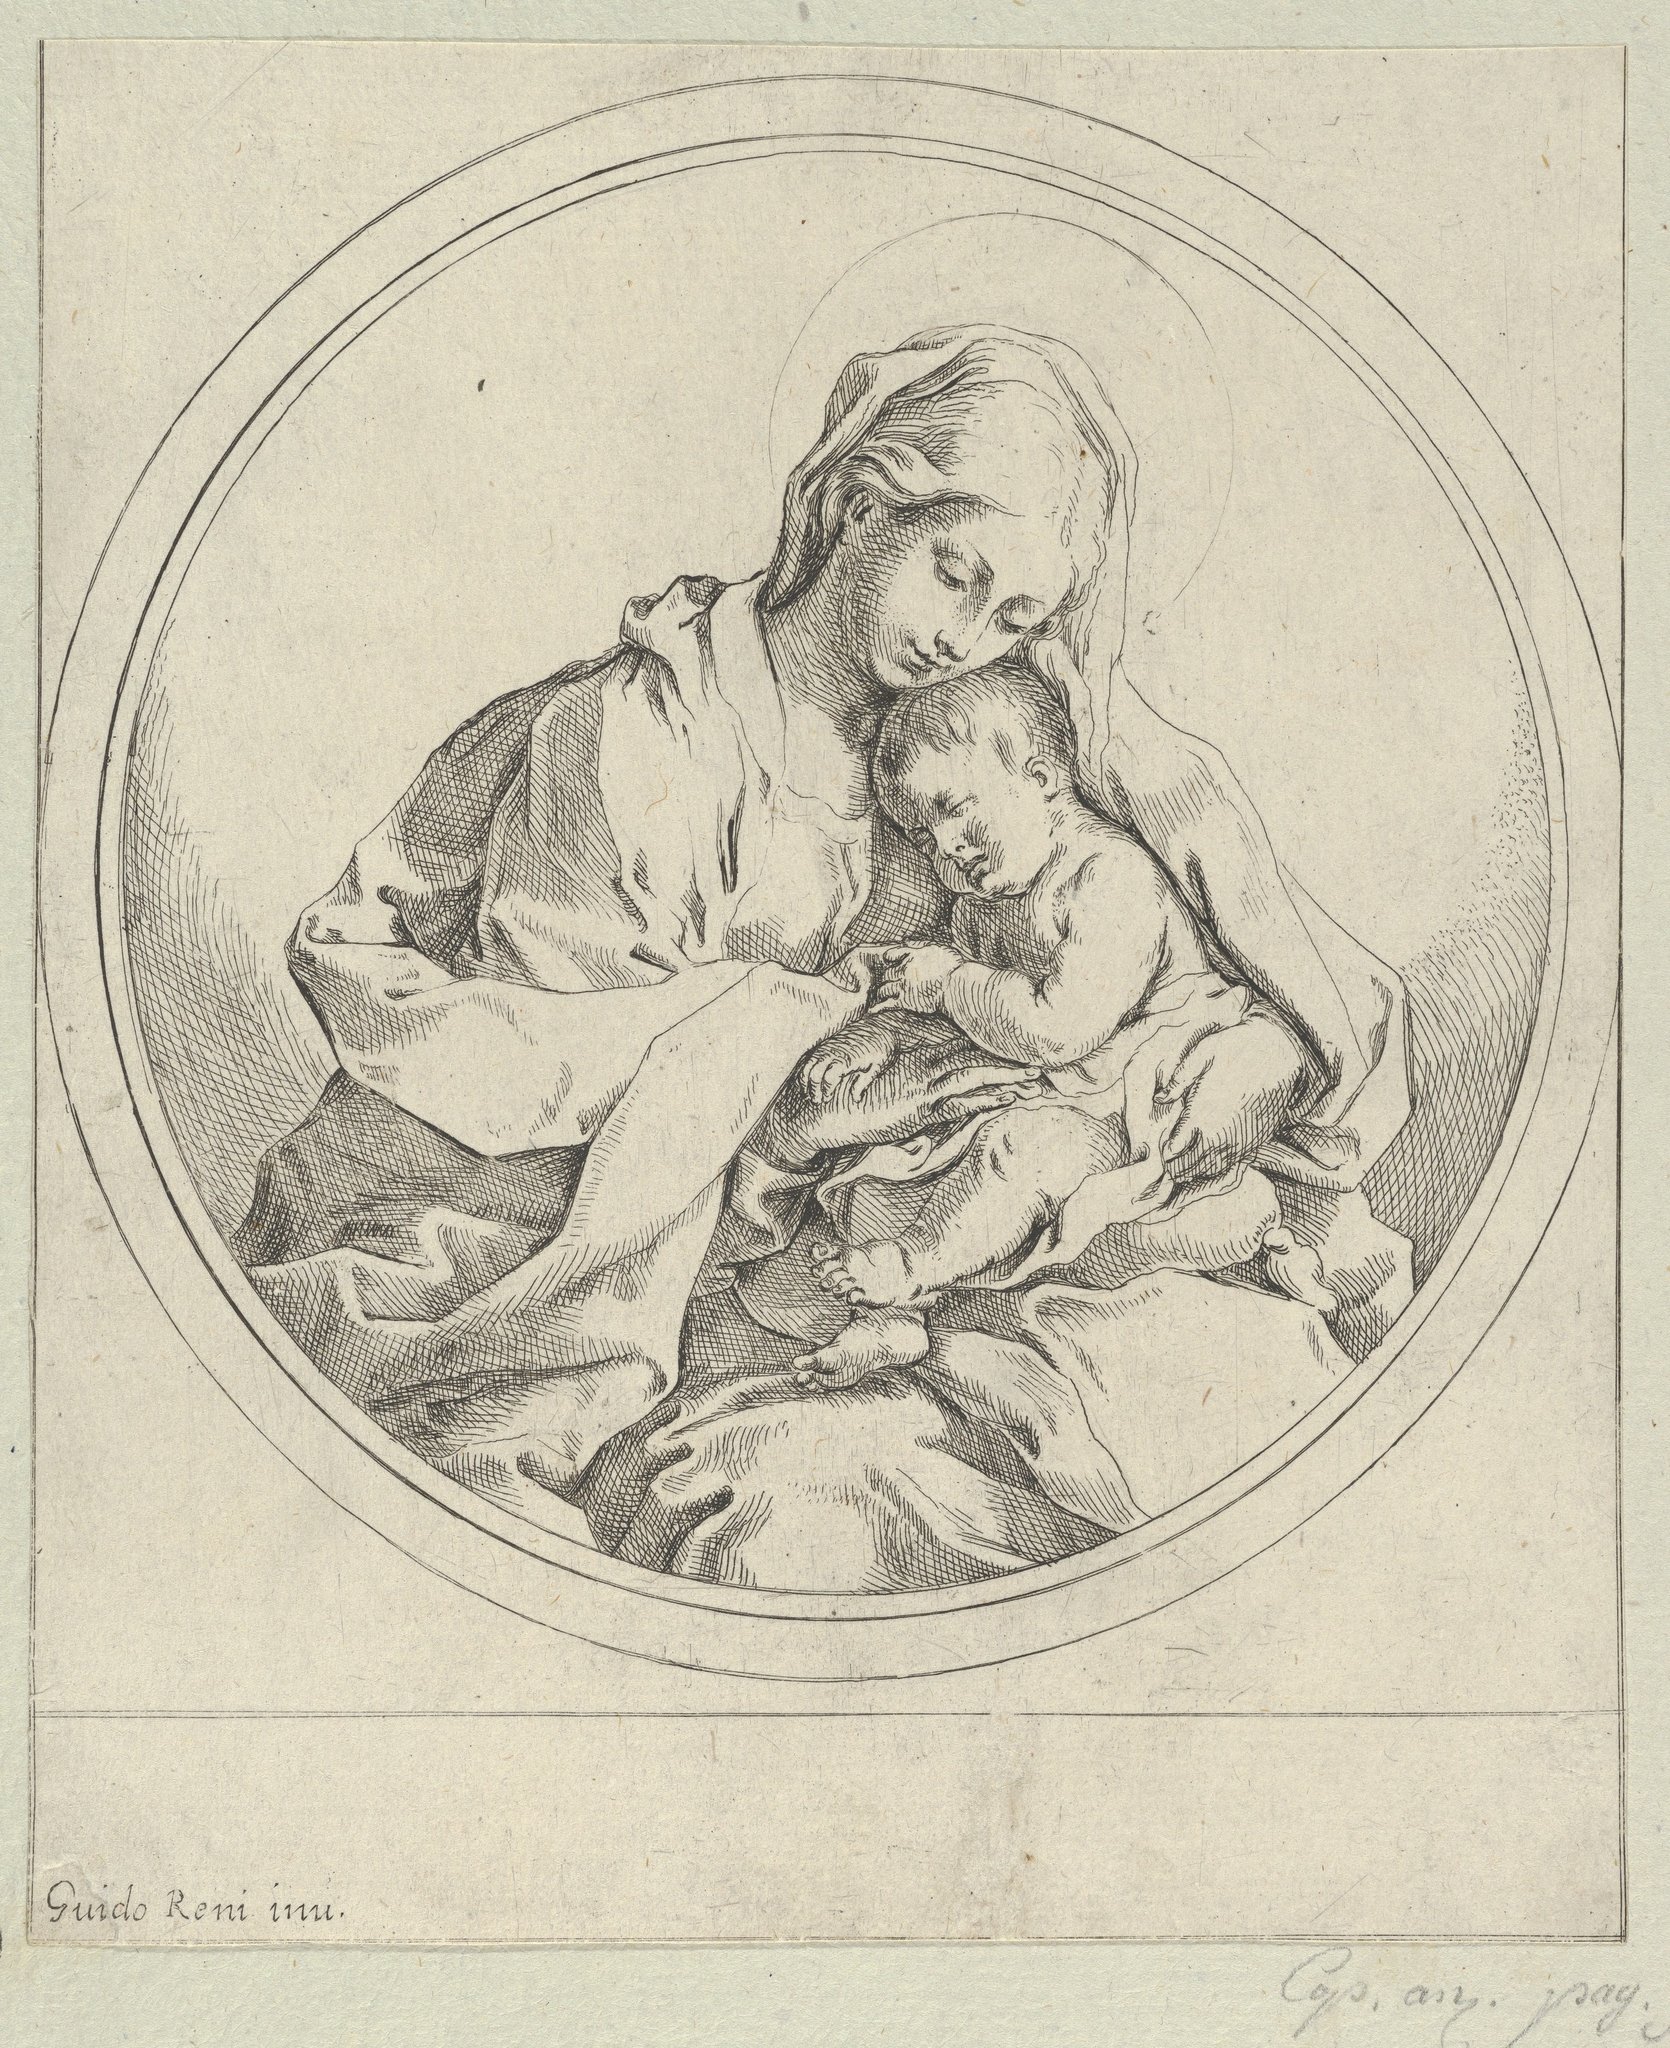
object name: print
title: The Virgin holding the infant Christ, a circular composition, after Reni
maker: anonymous, 17th century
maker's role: artist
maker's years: 1600-1700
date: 1600-1640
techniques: etching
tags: madonna and child